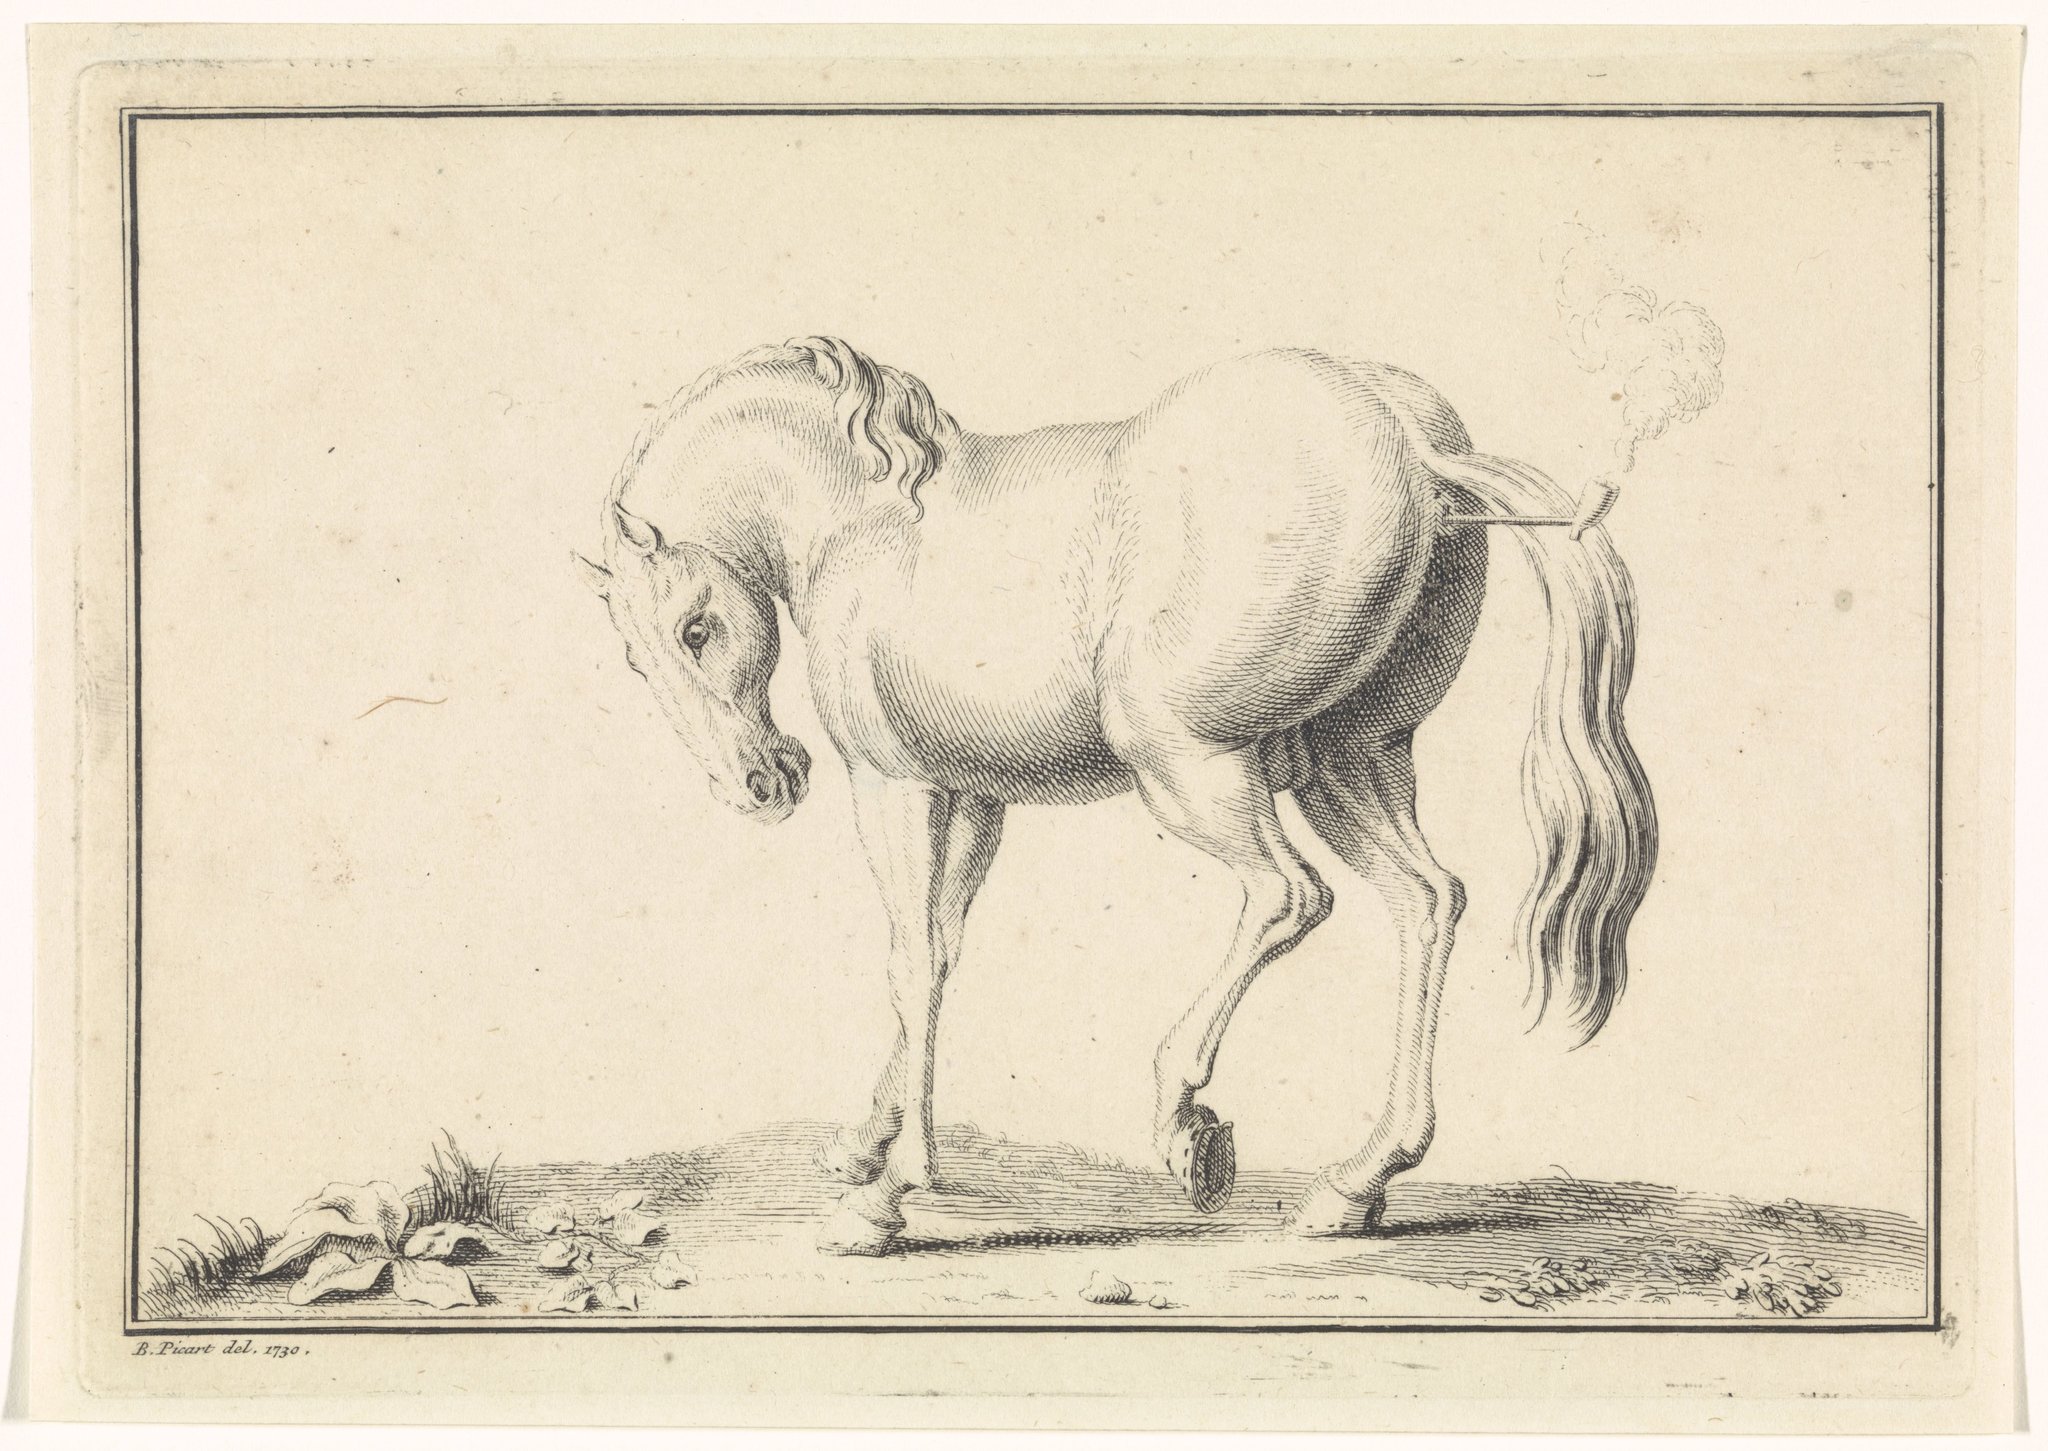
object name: book illustration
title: Landschap met paard dat van achteren een pijp rookt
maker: bernard picart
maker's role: draughtsman, print maker, publisher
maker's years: 1673-1733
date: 1730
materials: paper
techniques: engraving, etching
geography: amsterdam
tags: horse, pipe ~ tobacco (+ eating, drinking, smoking, chewing, etc. in secret, furtively)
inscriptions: collector's mark: Lugt 2233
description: Prent bedoeld voor: Chomel, Noel. Dictionnaire oeconomique, contenant divers moïens d'augmenter son bien, et de conserver sa santé. Amsterdam: Johannes Covens en Cornelis Mortier, 1732.